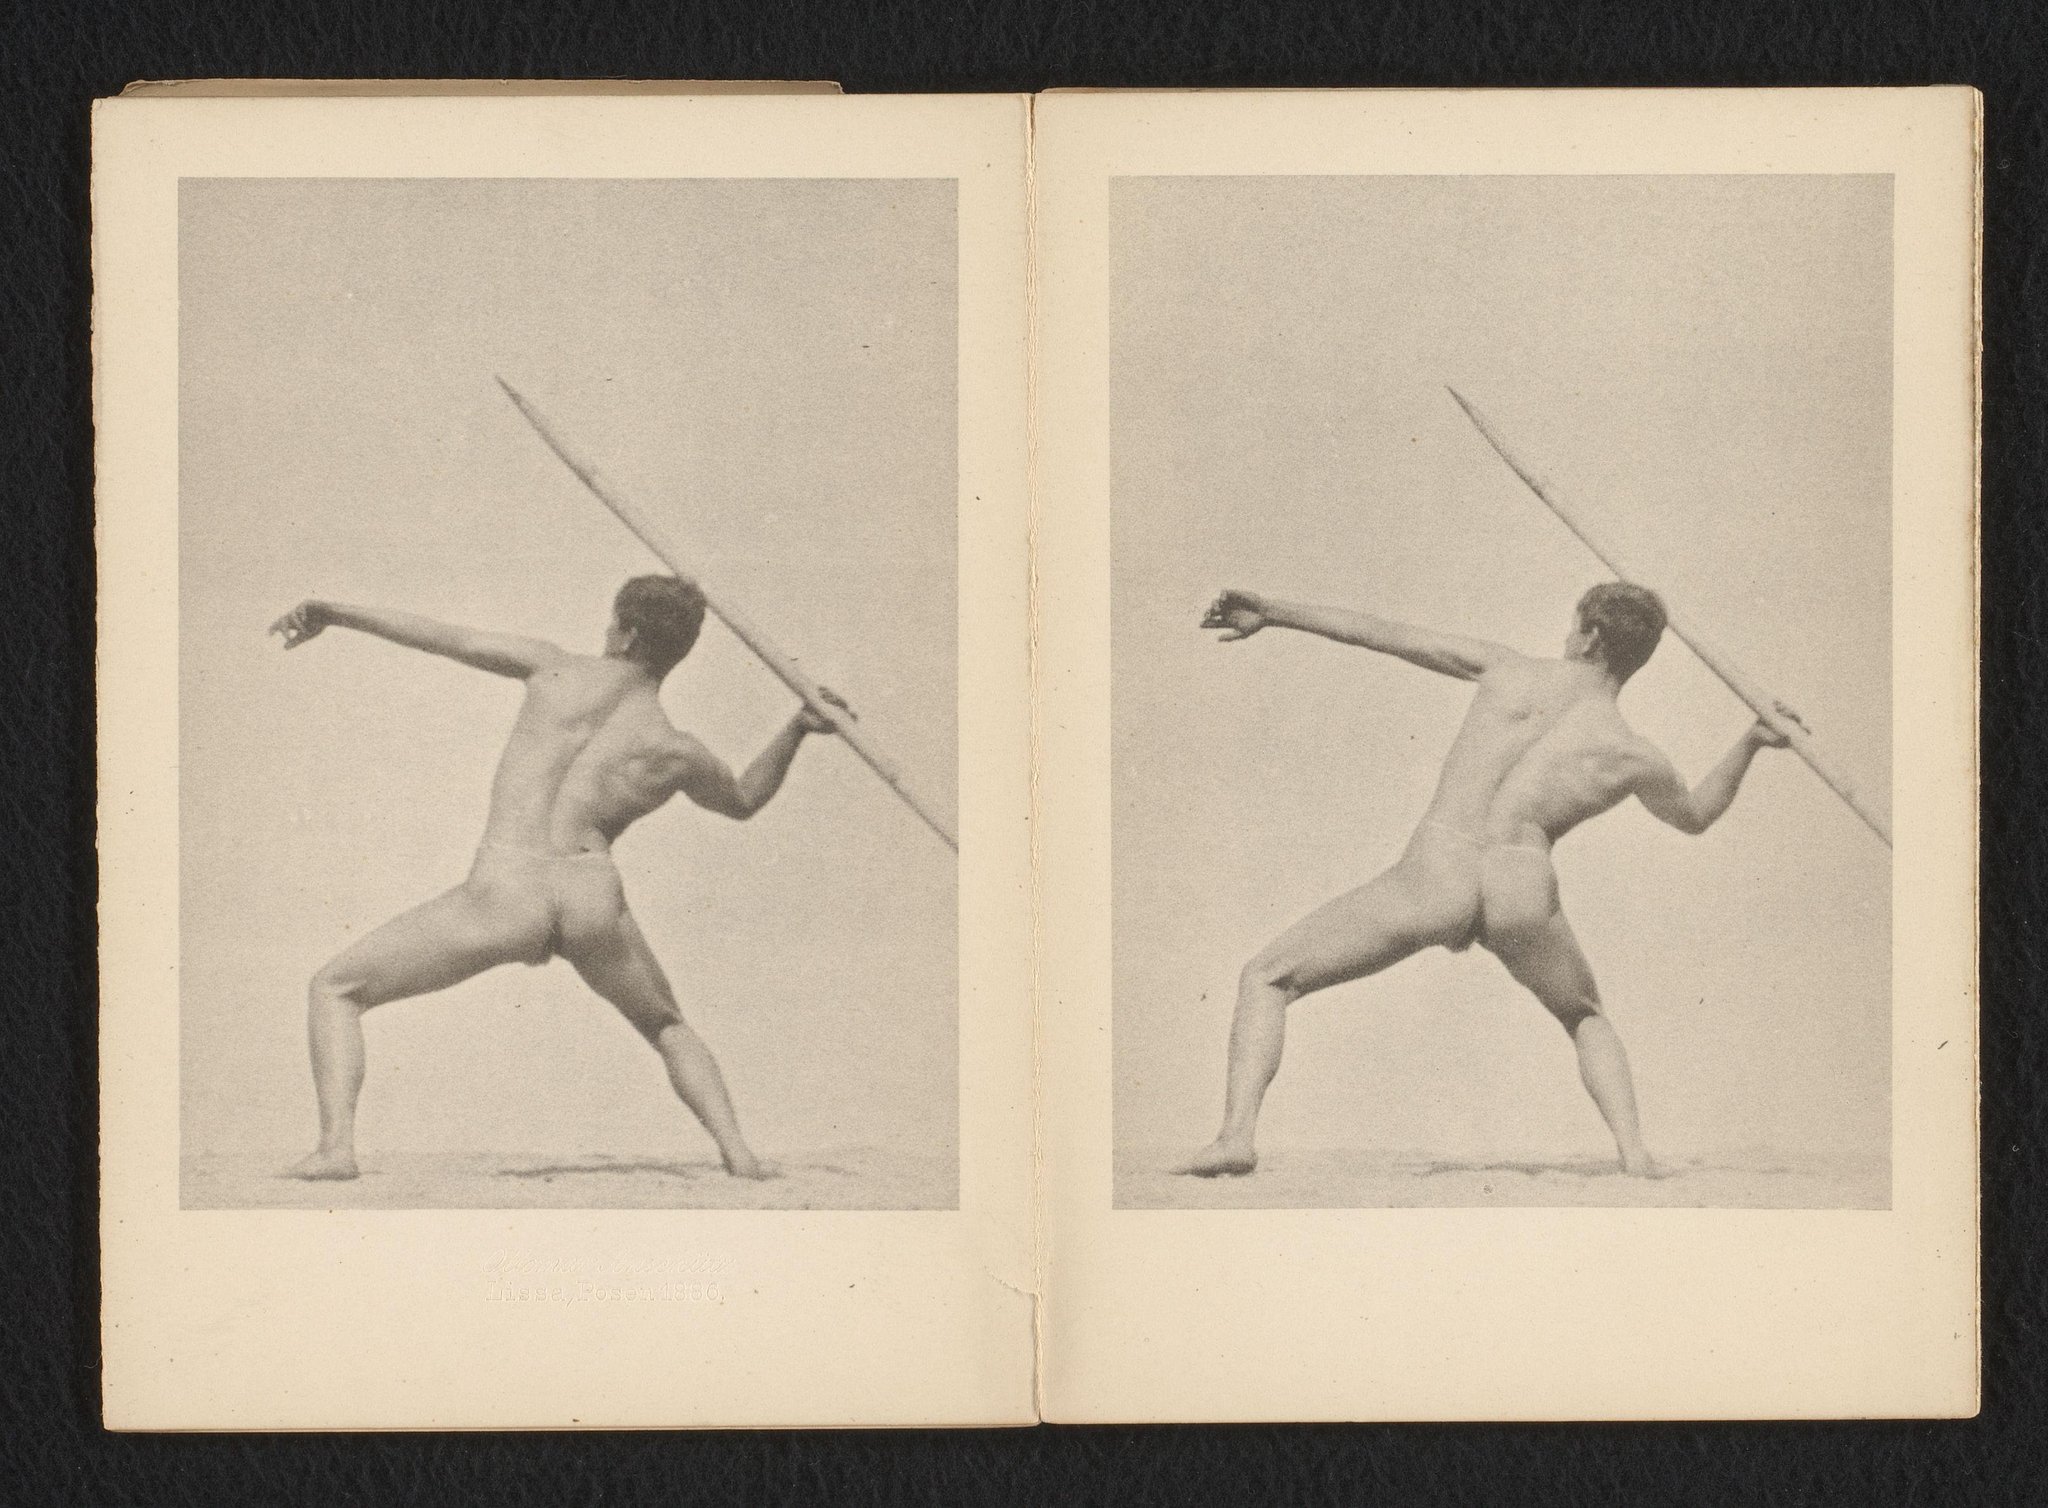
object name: photomechanical print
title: Man werpt een speer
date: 1886-1887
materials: paper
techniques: photograph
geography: lisse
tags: casting weapons: spear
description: Onderdeel van een sequentie van twaalf opnamen.